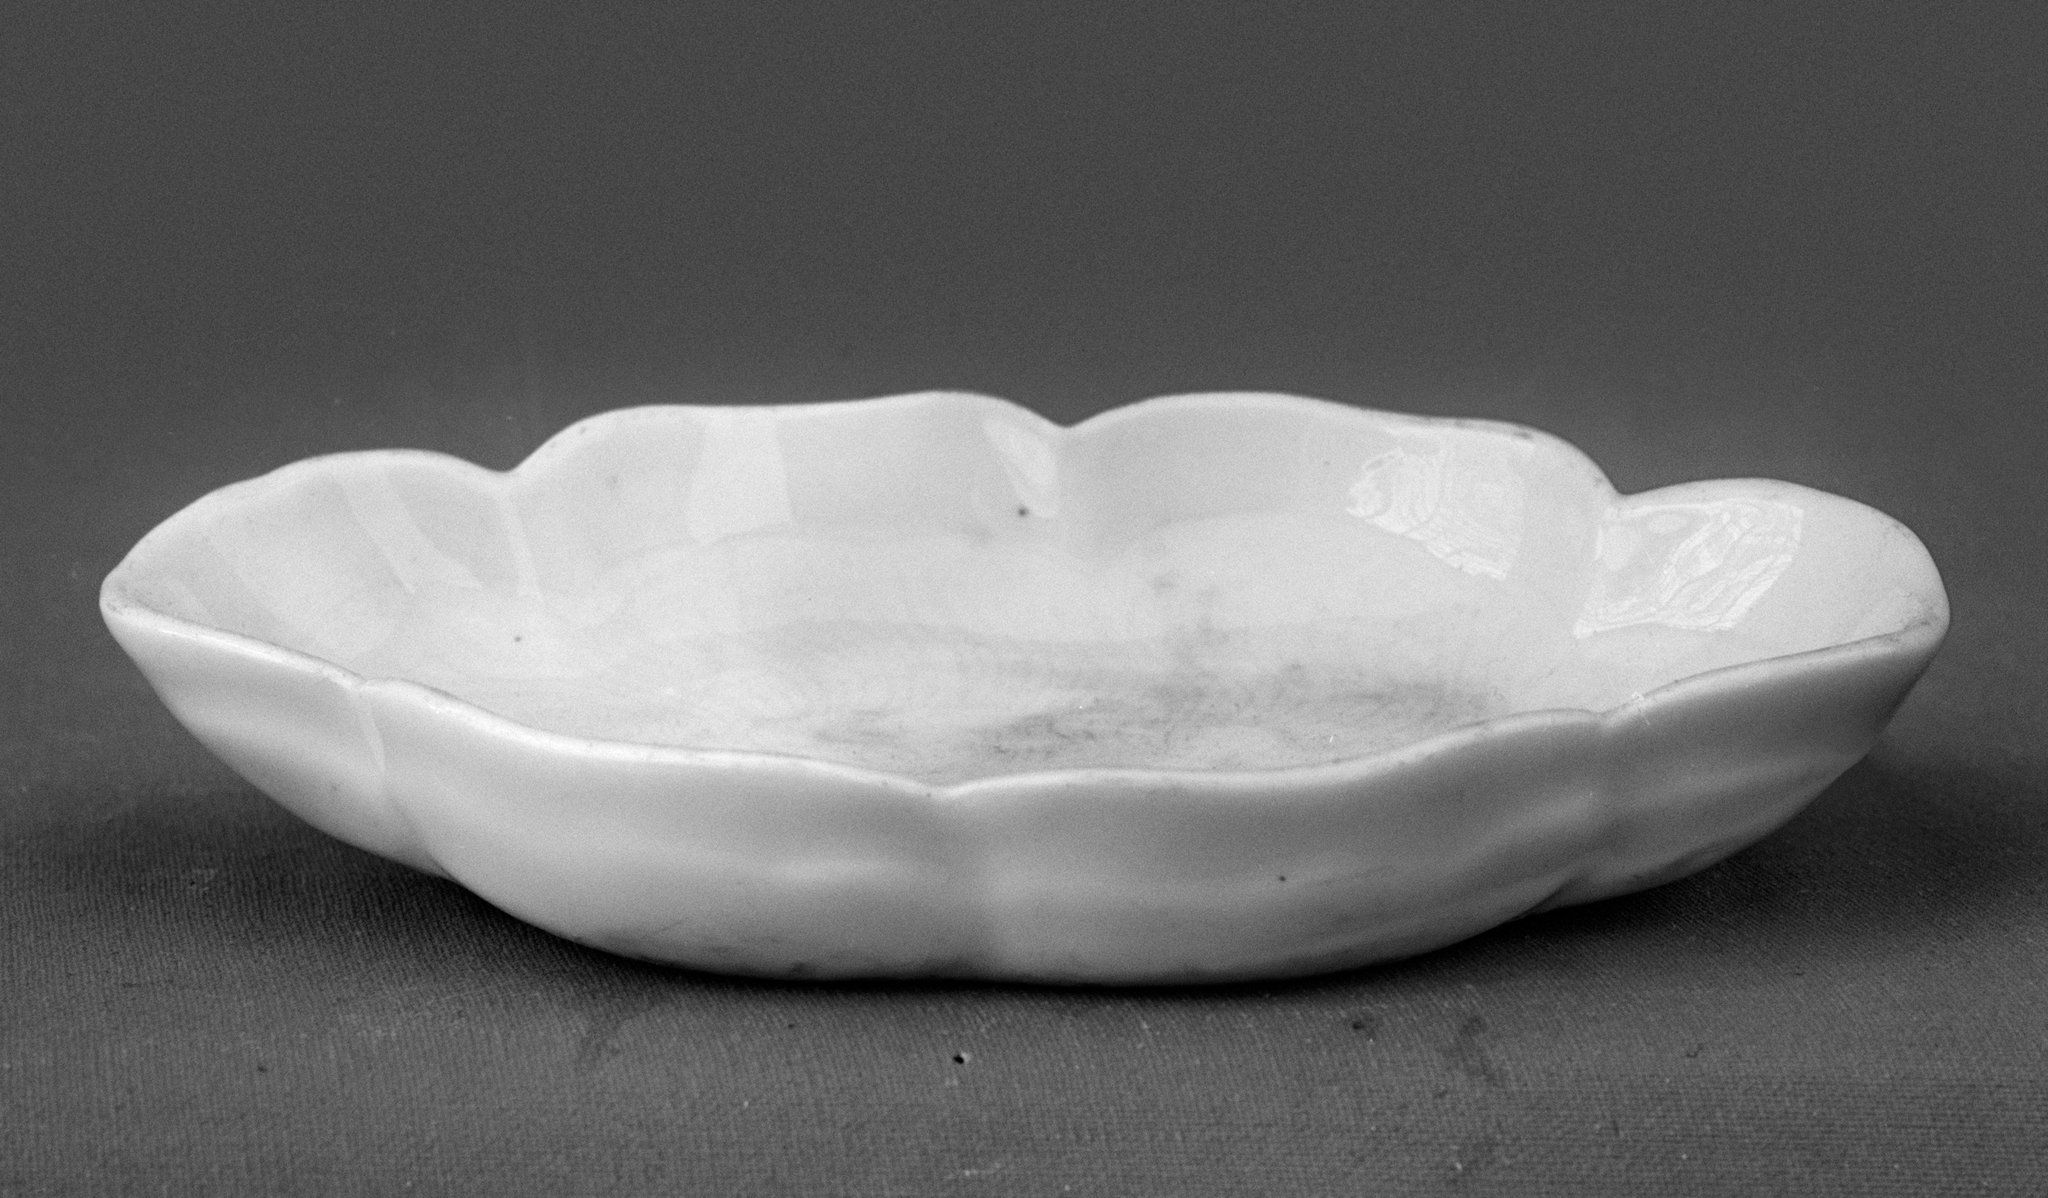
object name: saucer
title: Lobed dish with flowers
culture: chinese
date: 1701-1800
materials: glaze, porcelain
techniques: incising